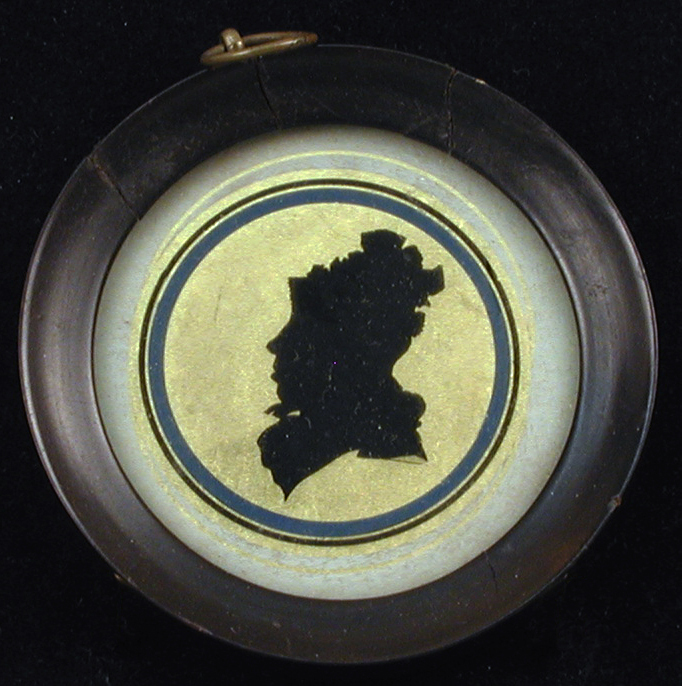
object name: medallion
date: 1801-1900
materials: glass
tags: human figures,profiles